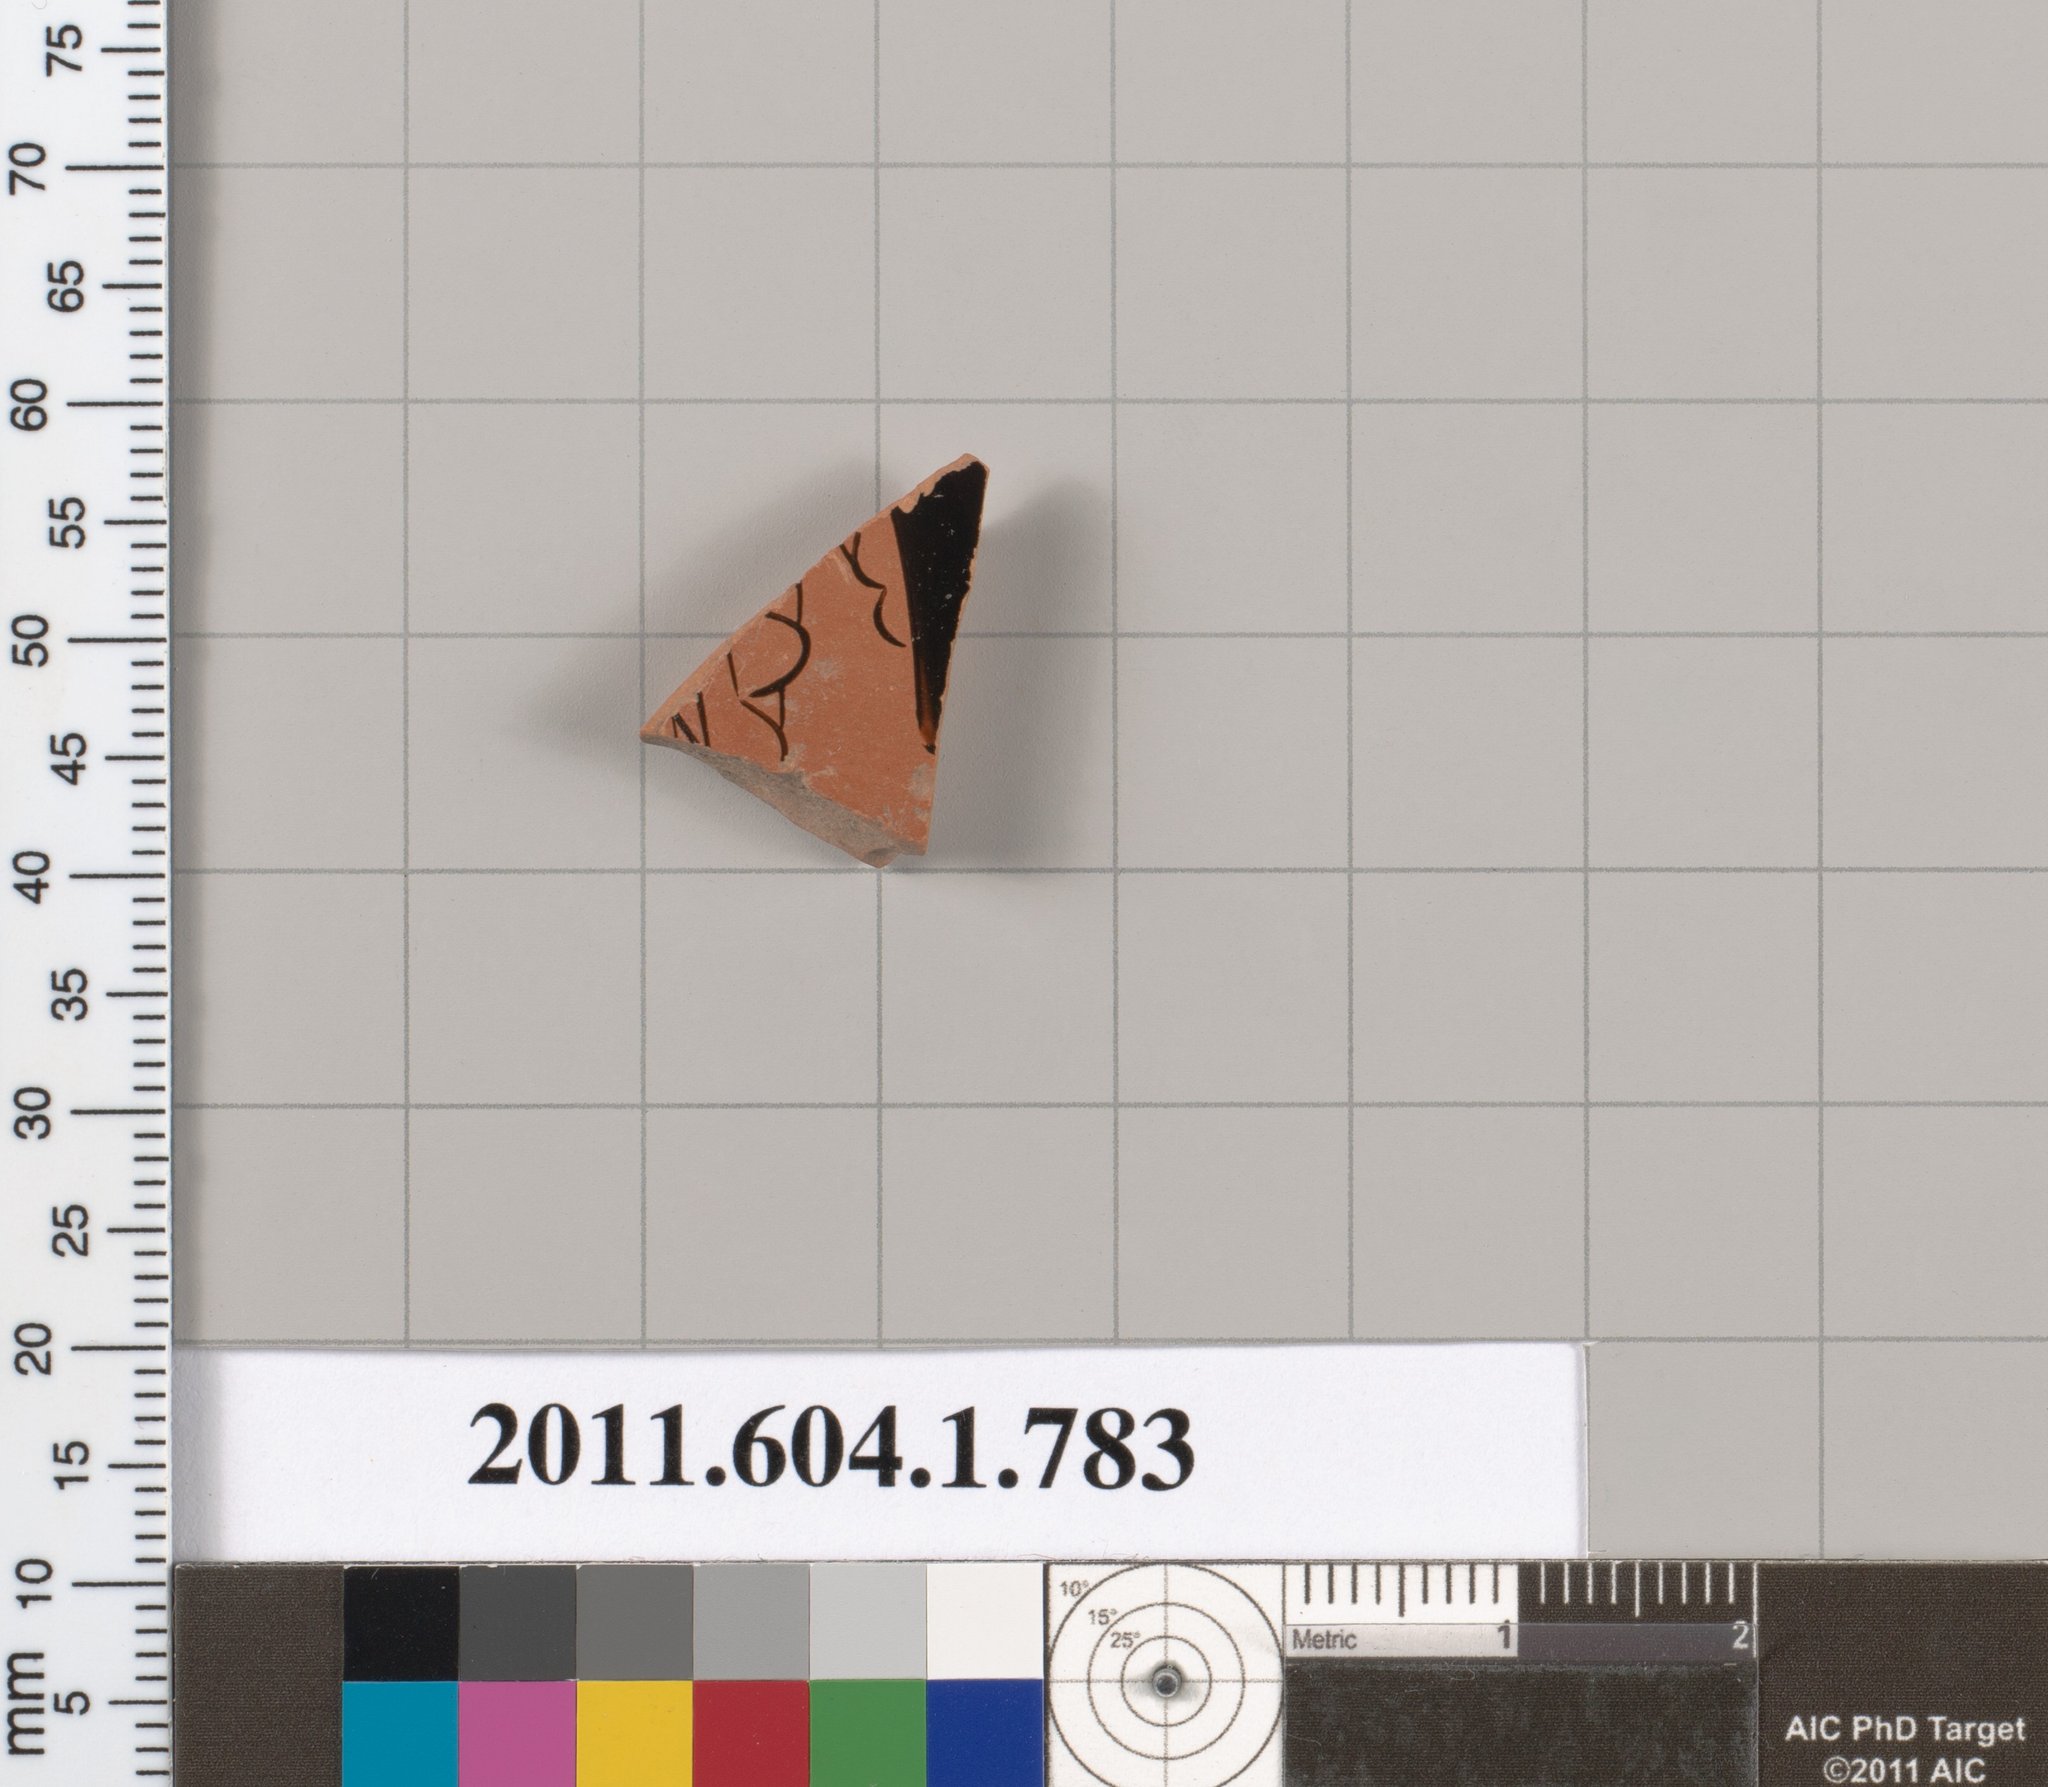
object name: kylix fragment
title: Terracotta fragment of a kylix (drinking cup)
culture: greek, attic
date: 490-480 BCE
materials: terracotta